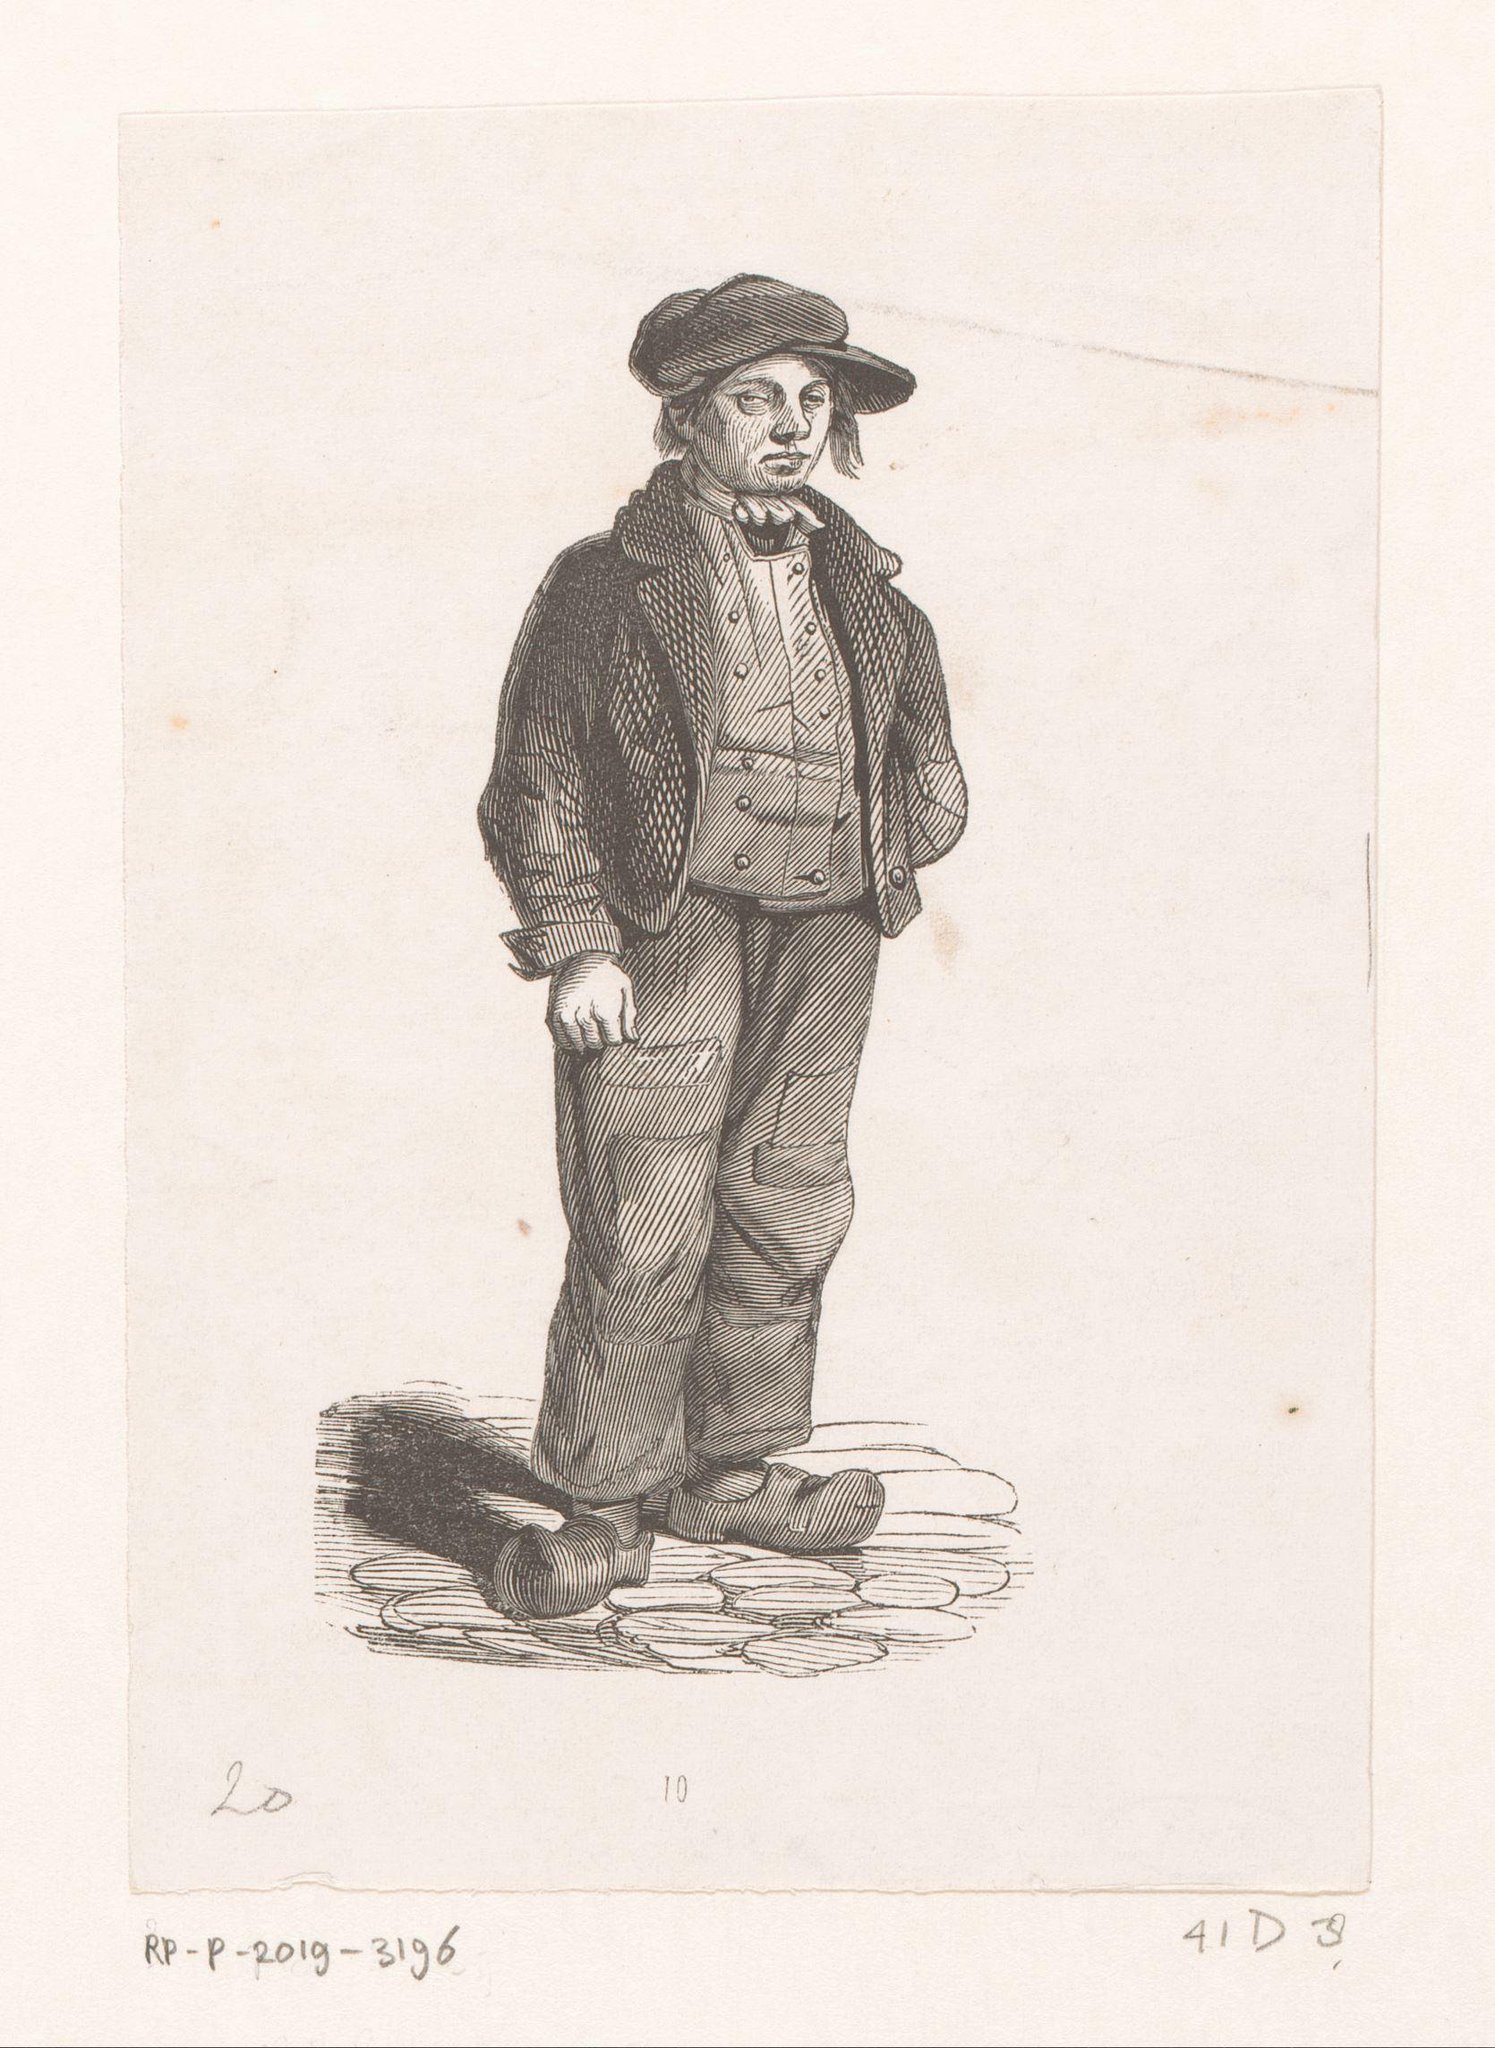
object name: print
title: Straatjongen, 1840-1841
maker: henry brown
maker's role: print maker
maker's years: 1816-1870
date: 1841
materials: paper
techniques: engraving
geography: netherlands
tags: professional clothes, wooden shoes, clogs, folk costume, regional costume, the poor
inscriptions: collector's mark: Lugt 2228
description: Gebruikt als illustratie in: De Nederlanden : karakterschetsen, kleederdrachten, houding en voorkomen van verschillende standen : tekst van de meest geachte schrijvers : met gravuren van Henry Brown naar teekeningen van de voornaamste Nederlandsche kunstenaars. Den Haag: Nederlandsche Maatschappij van Schoone Kunsten, 1841. Zie ook BI-B-FM-124-0.